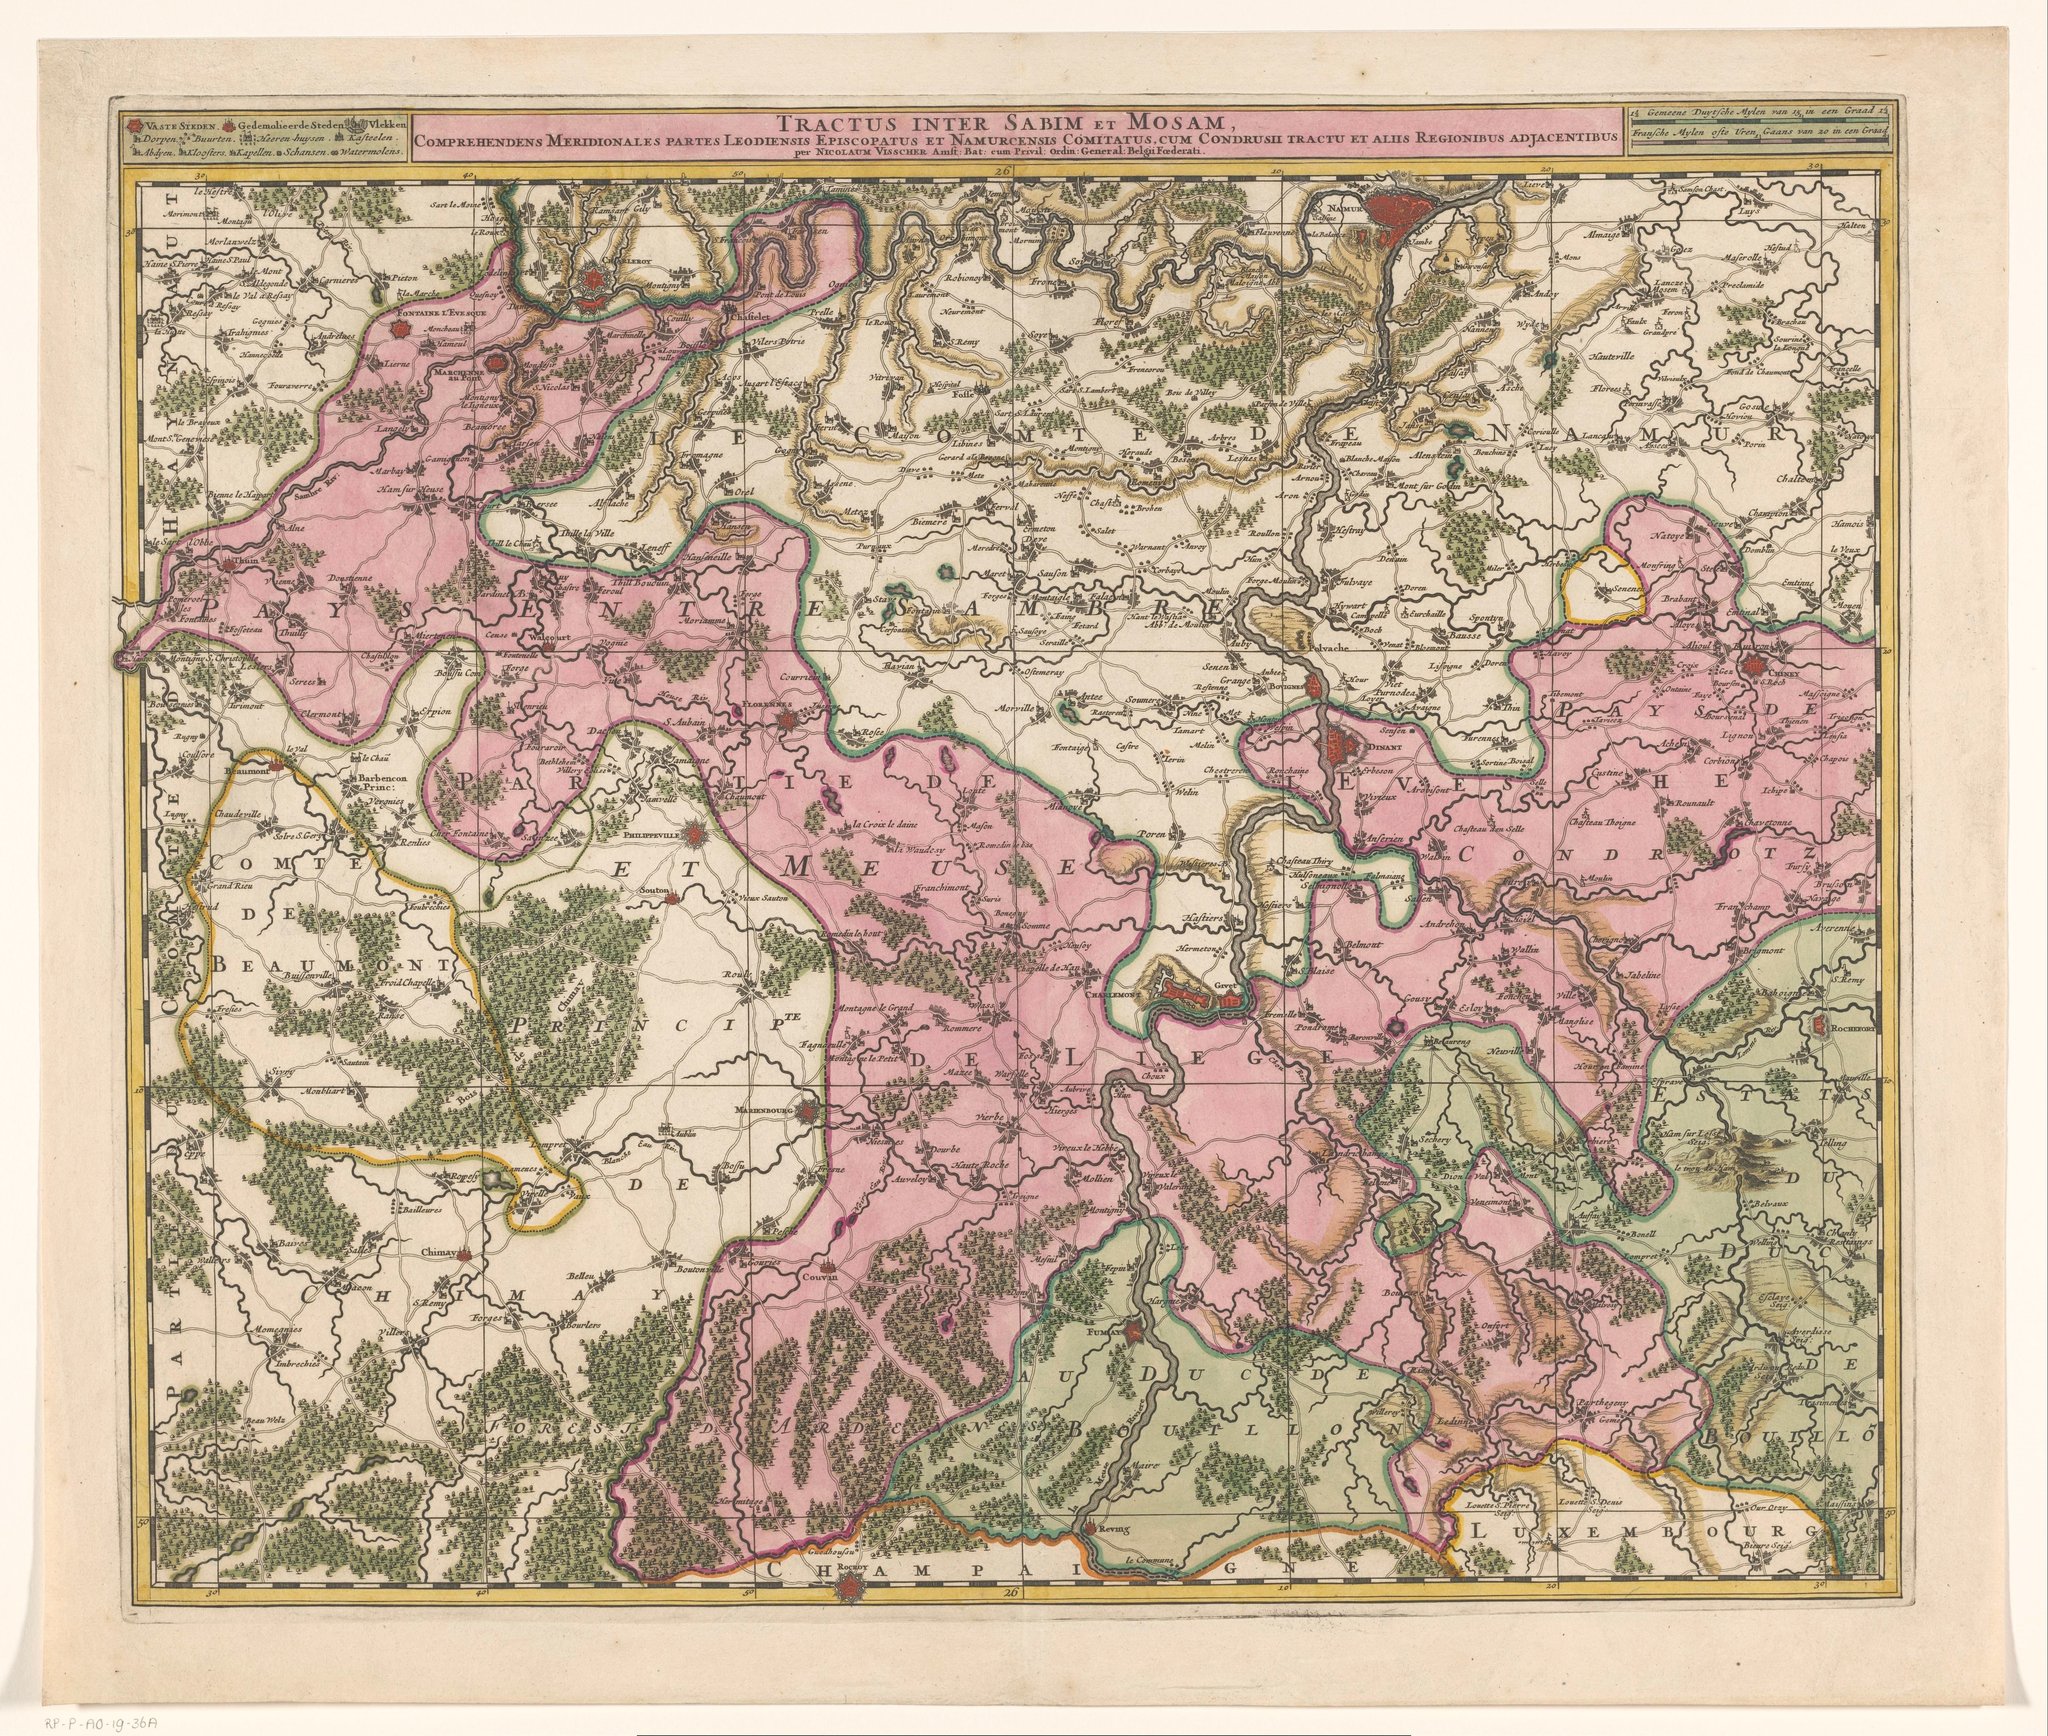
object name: print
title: Tractus inter Sabim et Mosam (...)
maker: Anonymous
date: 1677-1720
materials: paper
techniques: engraving, etching, hand coloring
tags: maps of separate countries or regions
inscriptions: collector's mark: Lugt 2228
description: Kaart van de streek tussen de Samber en de Maas. In een balk boven de kaart, in het midden, de titel. Links hiervan een legenda. Rechts van de titel twee schaalstokken: 1 1/2 Gemeene Duytsche Mijlen van 15 in een Graad / 2 Fransche Mylen ofte Uren Gaans van 20 in een Graad. De kaart is voorzien van een coördinaten-net en een gradenverdeling.